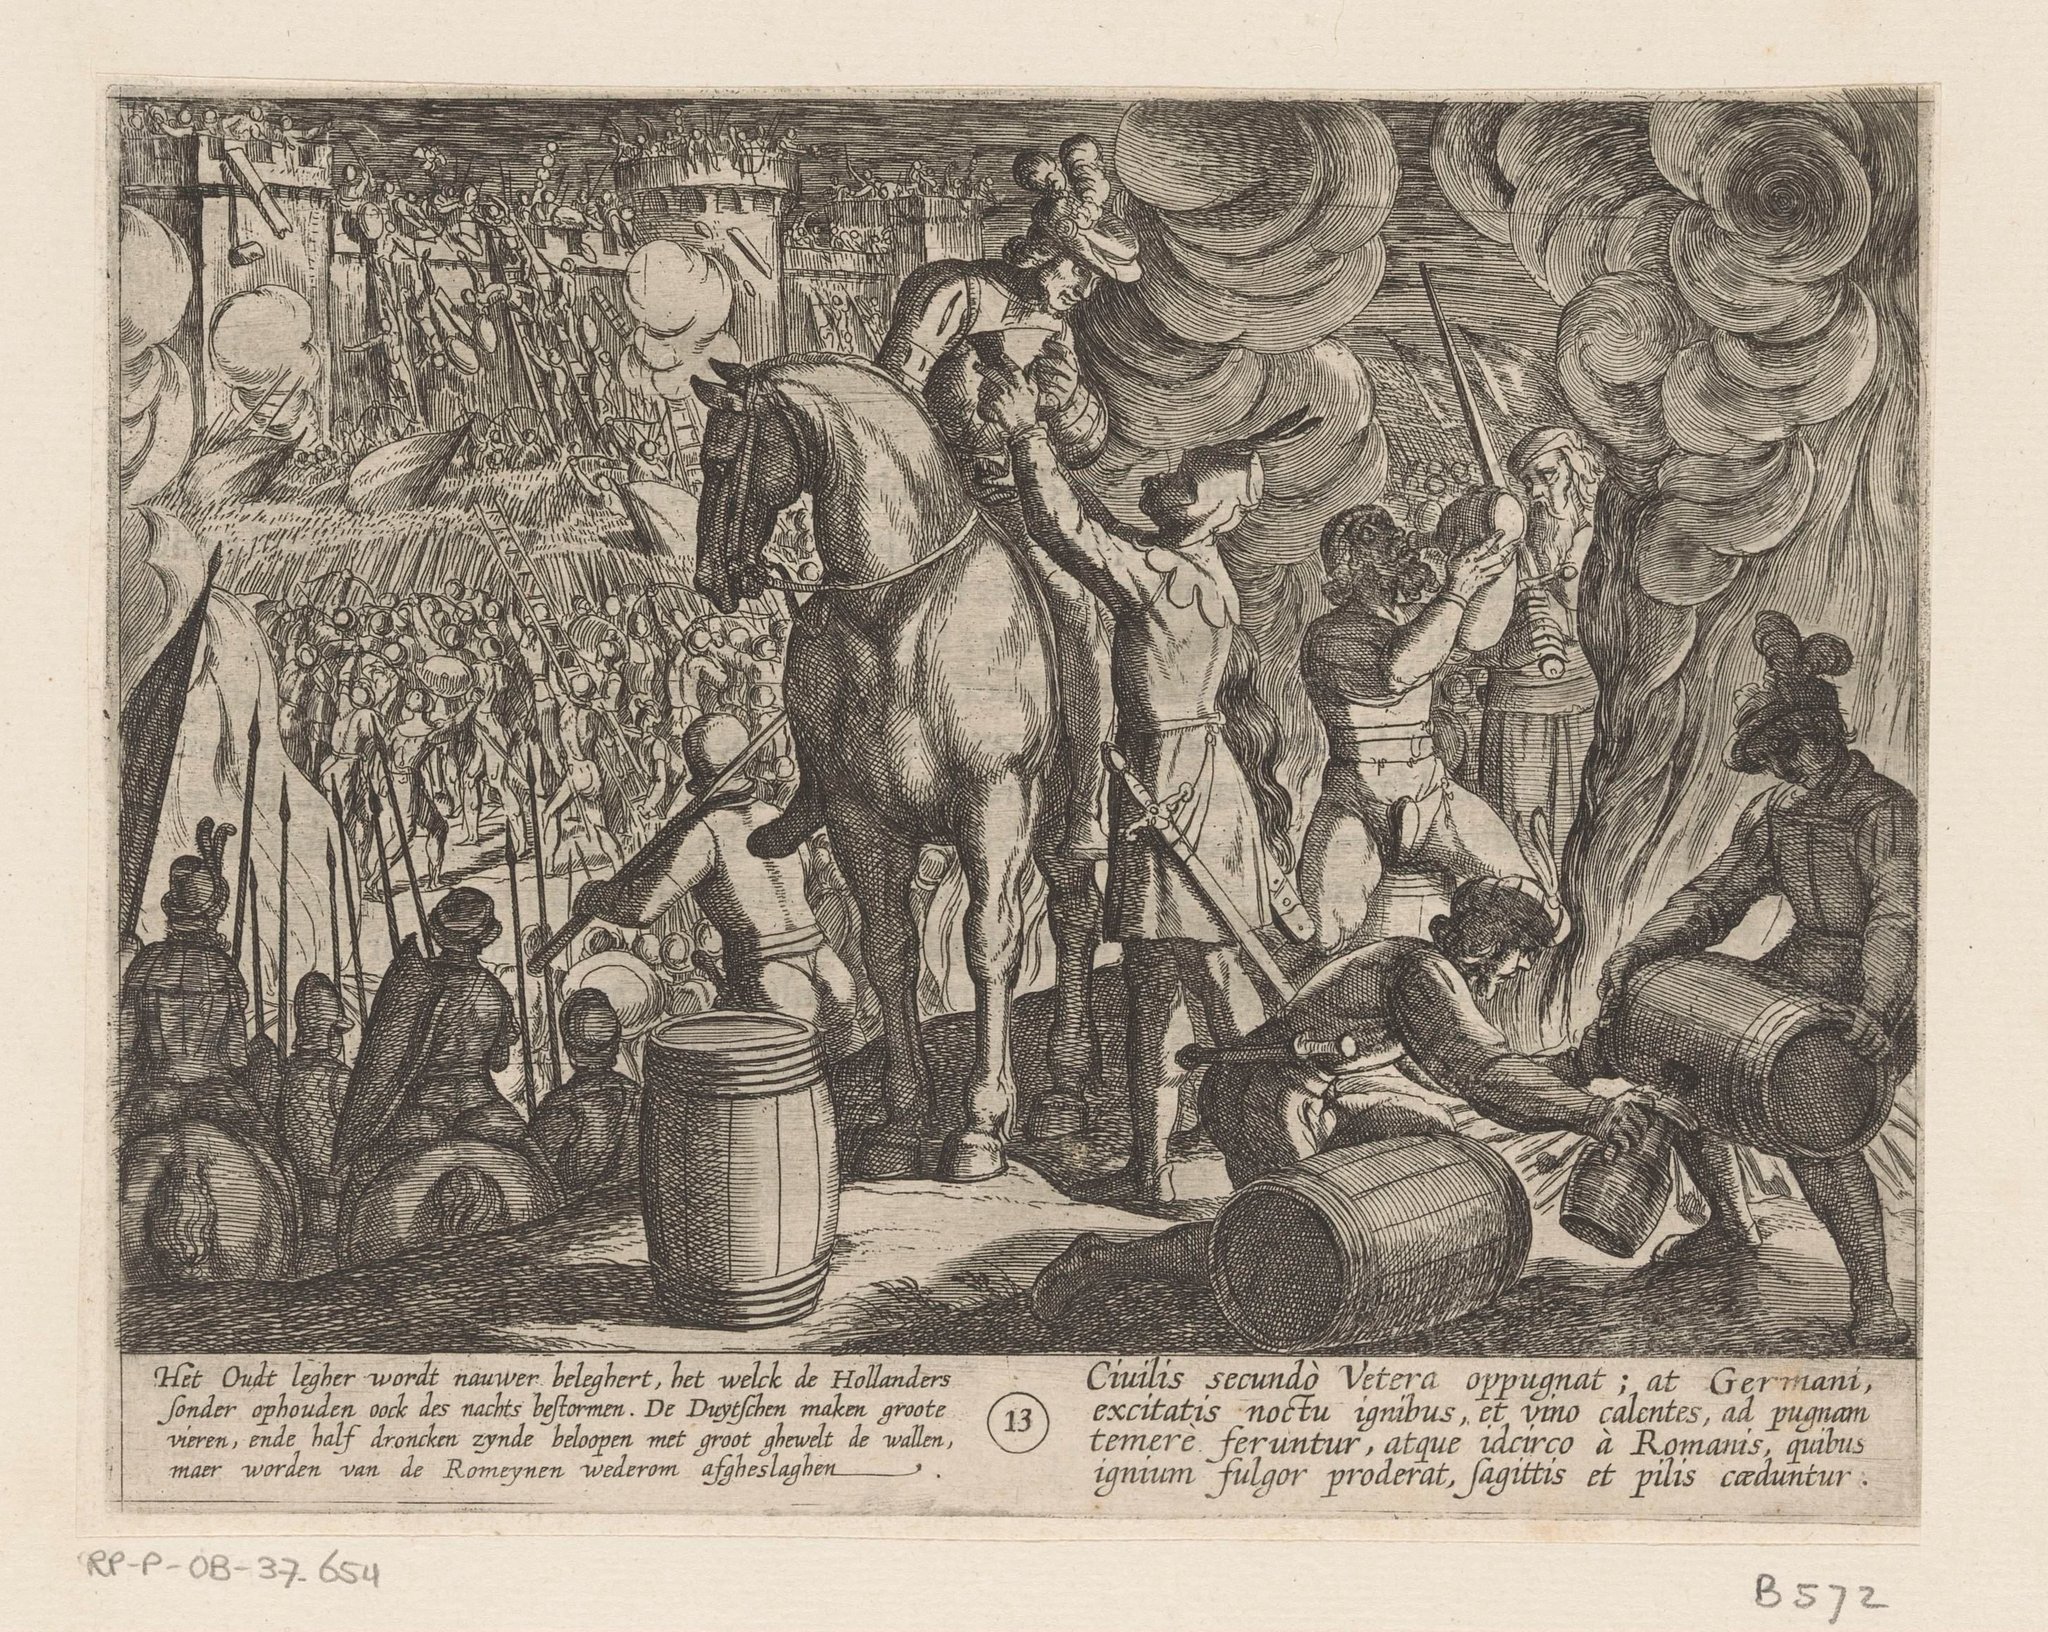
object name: print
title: Aanval 's nachts op een Romeins fort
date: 1611-1612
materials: paper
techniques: etching, letterpress printing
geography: southern netherlands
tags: fortress, battle, the soldier; the soldier's life, (story of) julius claudius civilis, extinct, 'historical' peoples (with name)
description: Nederlandse en Duitse troepen bestormen gezamenlijk een Romeins fort (Castra Vetera) tijdens een nachtelijke aanval. Op de voorgrond zit Julius Civilis op zijn paard. Onderschrift in het Nederlands en in het Latijn.